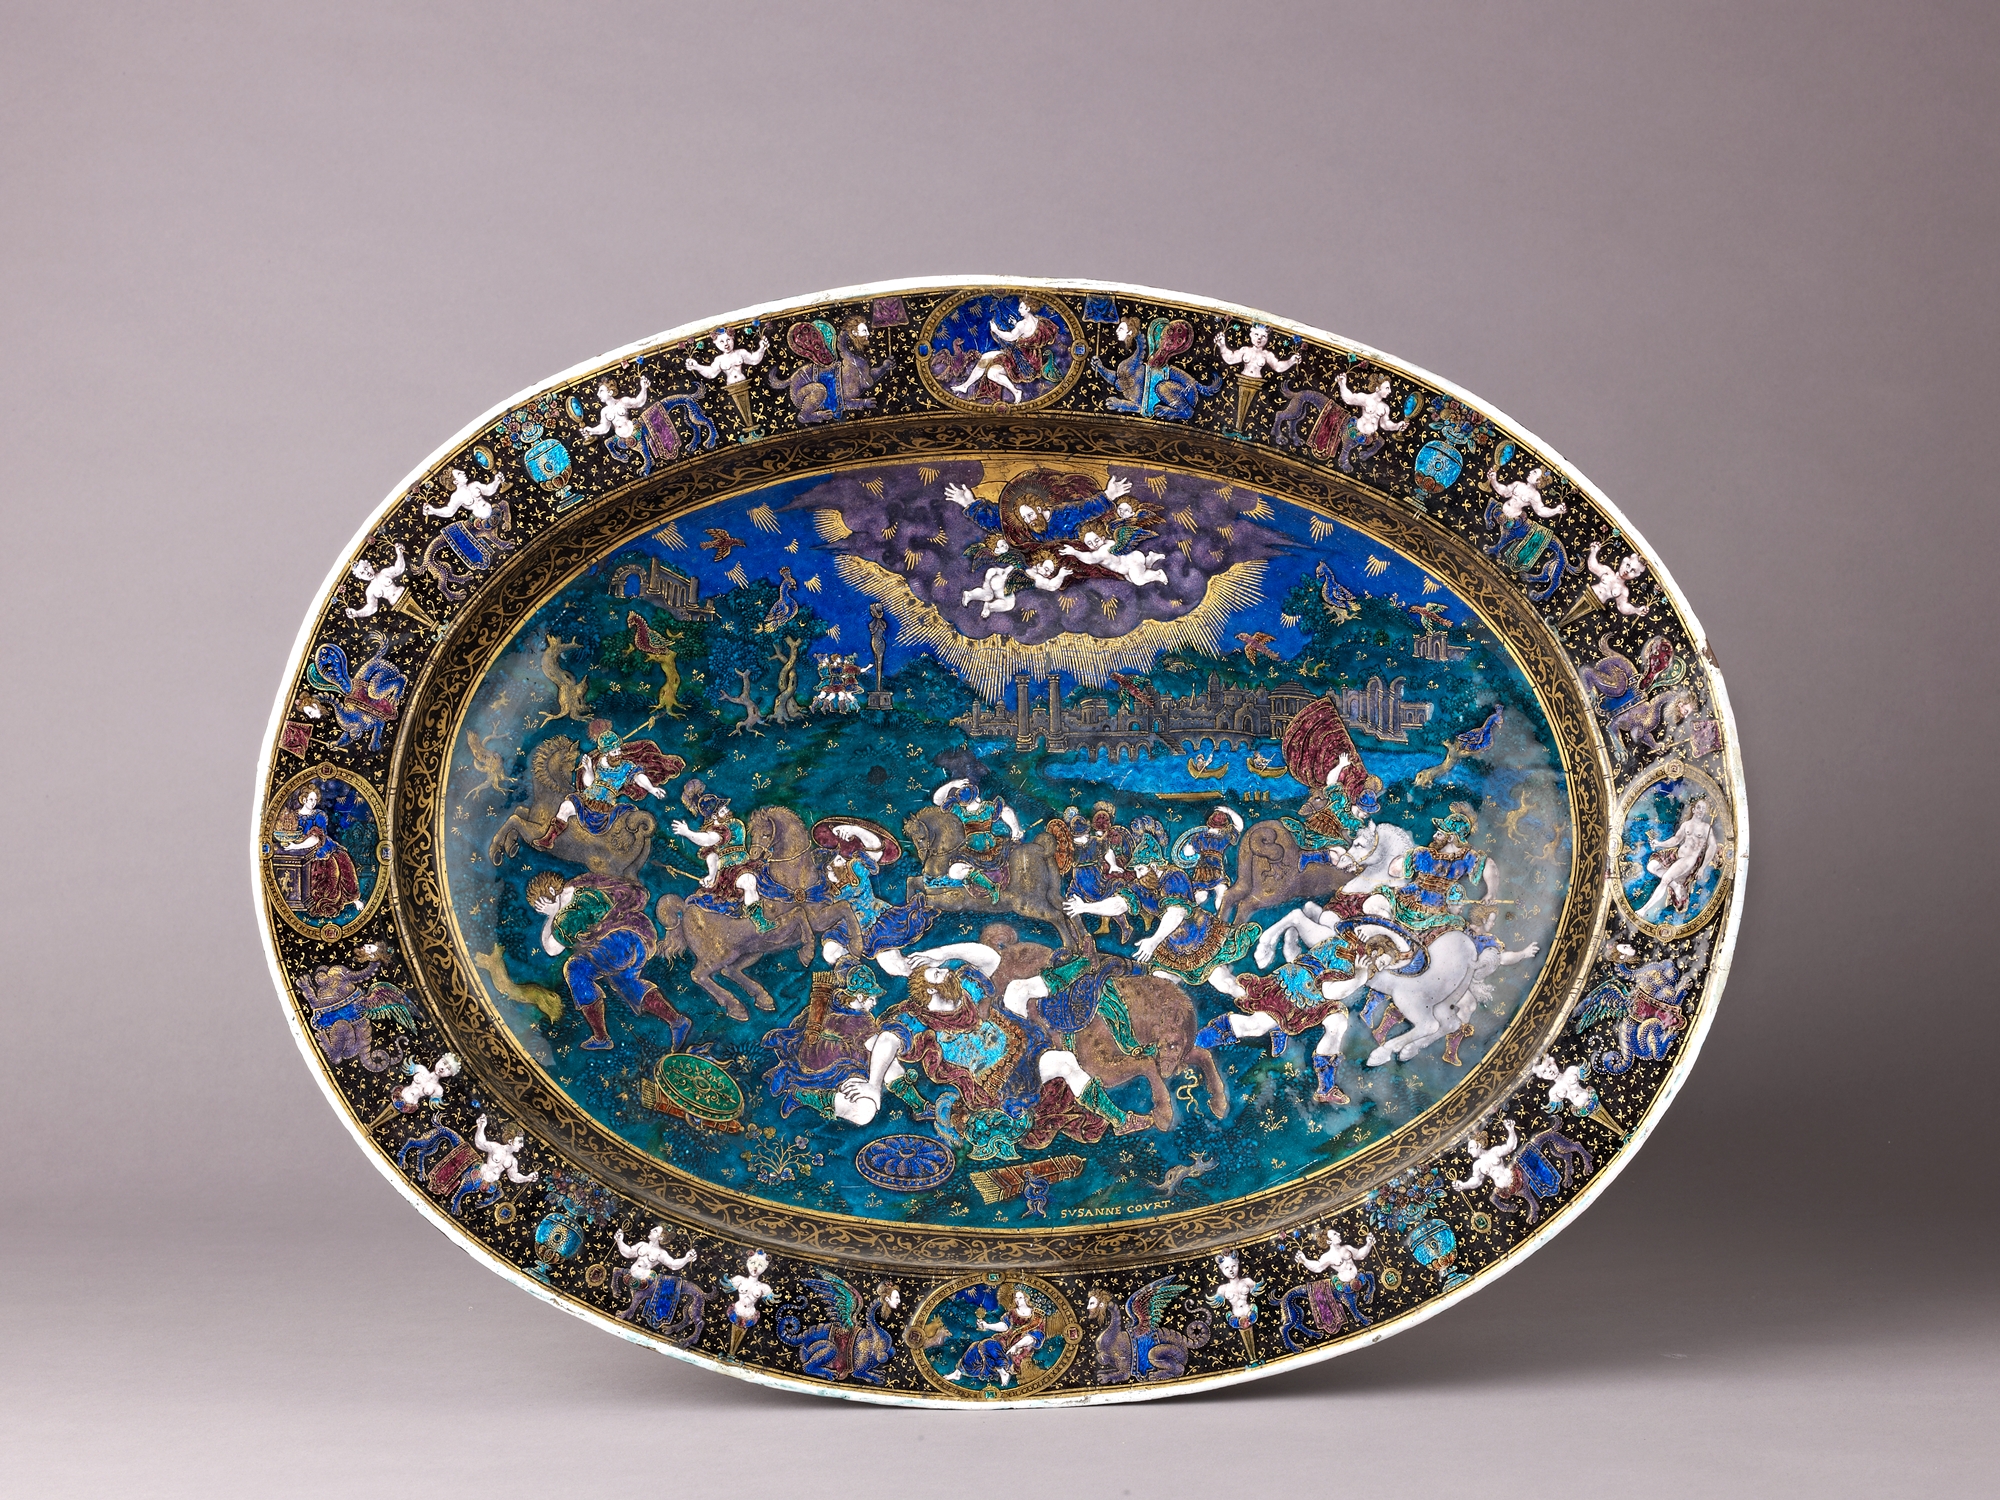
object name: dish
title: Conversion St. Paul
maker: suzanne de court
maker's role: artist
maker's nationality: french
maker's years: 1575-1625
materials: copper, enamel, gilt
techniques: painting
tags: battles,soldiers,horses,angels